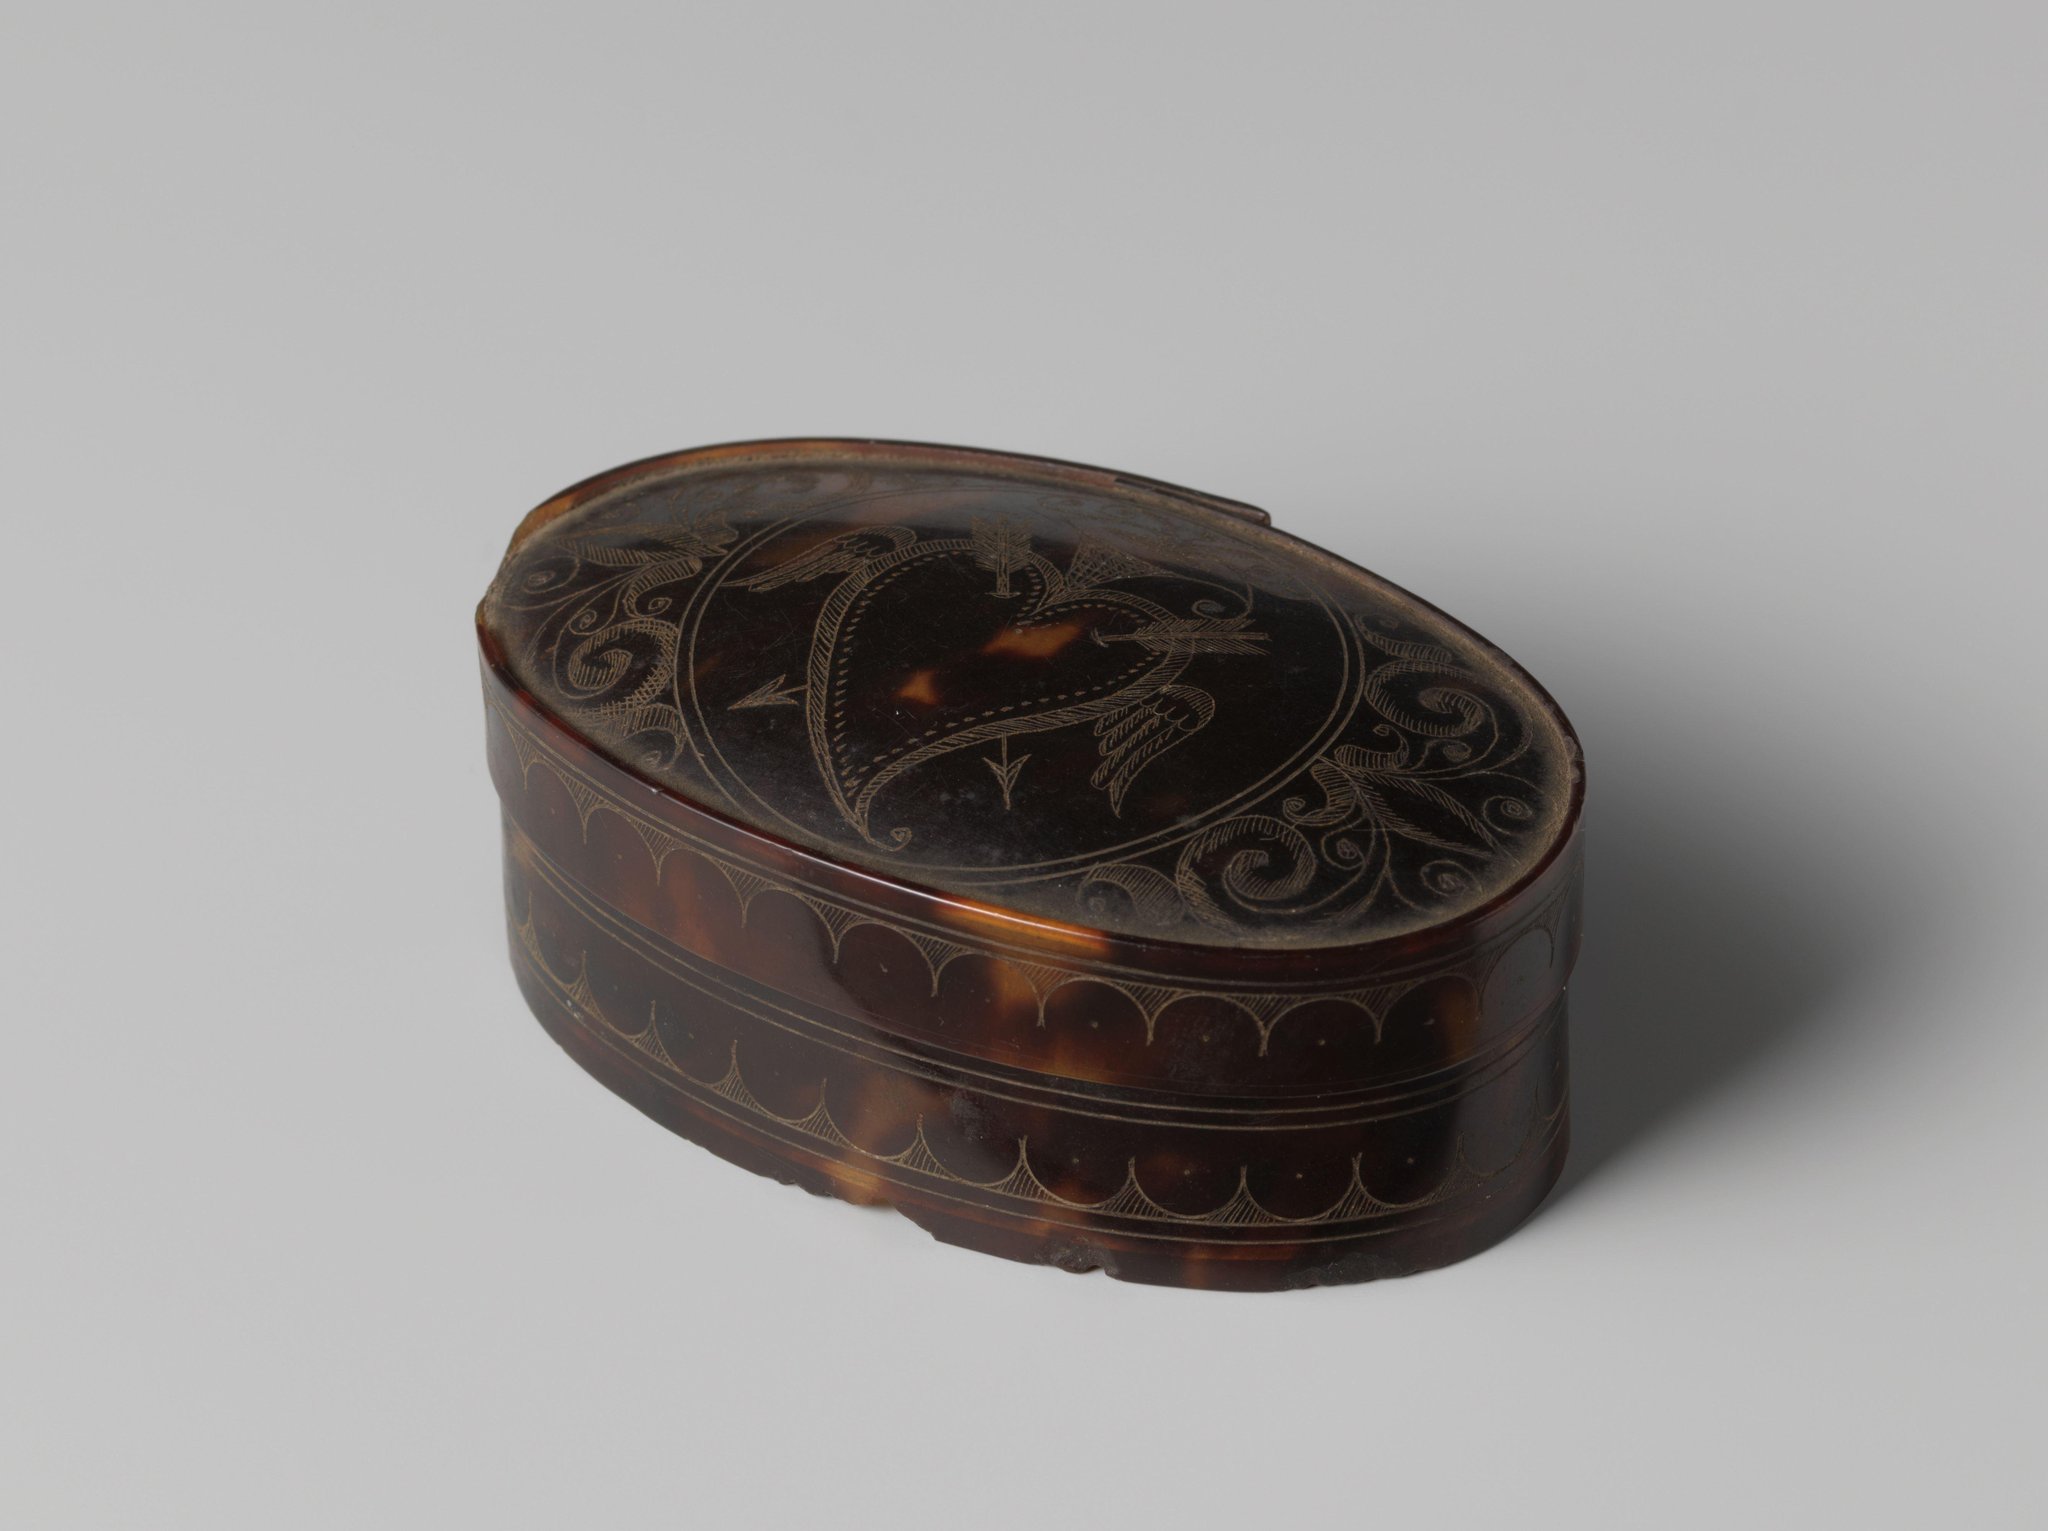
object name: box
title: Snuifdoos, ovaal, van schildpad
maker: Anonymous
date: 1675-1700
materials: shell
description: Snuifdoos, ovaal, van schildpad, waarop gesneden een met twee pijlen doorboord gevleugeld hart en andere ornamenten.